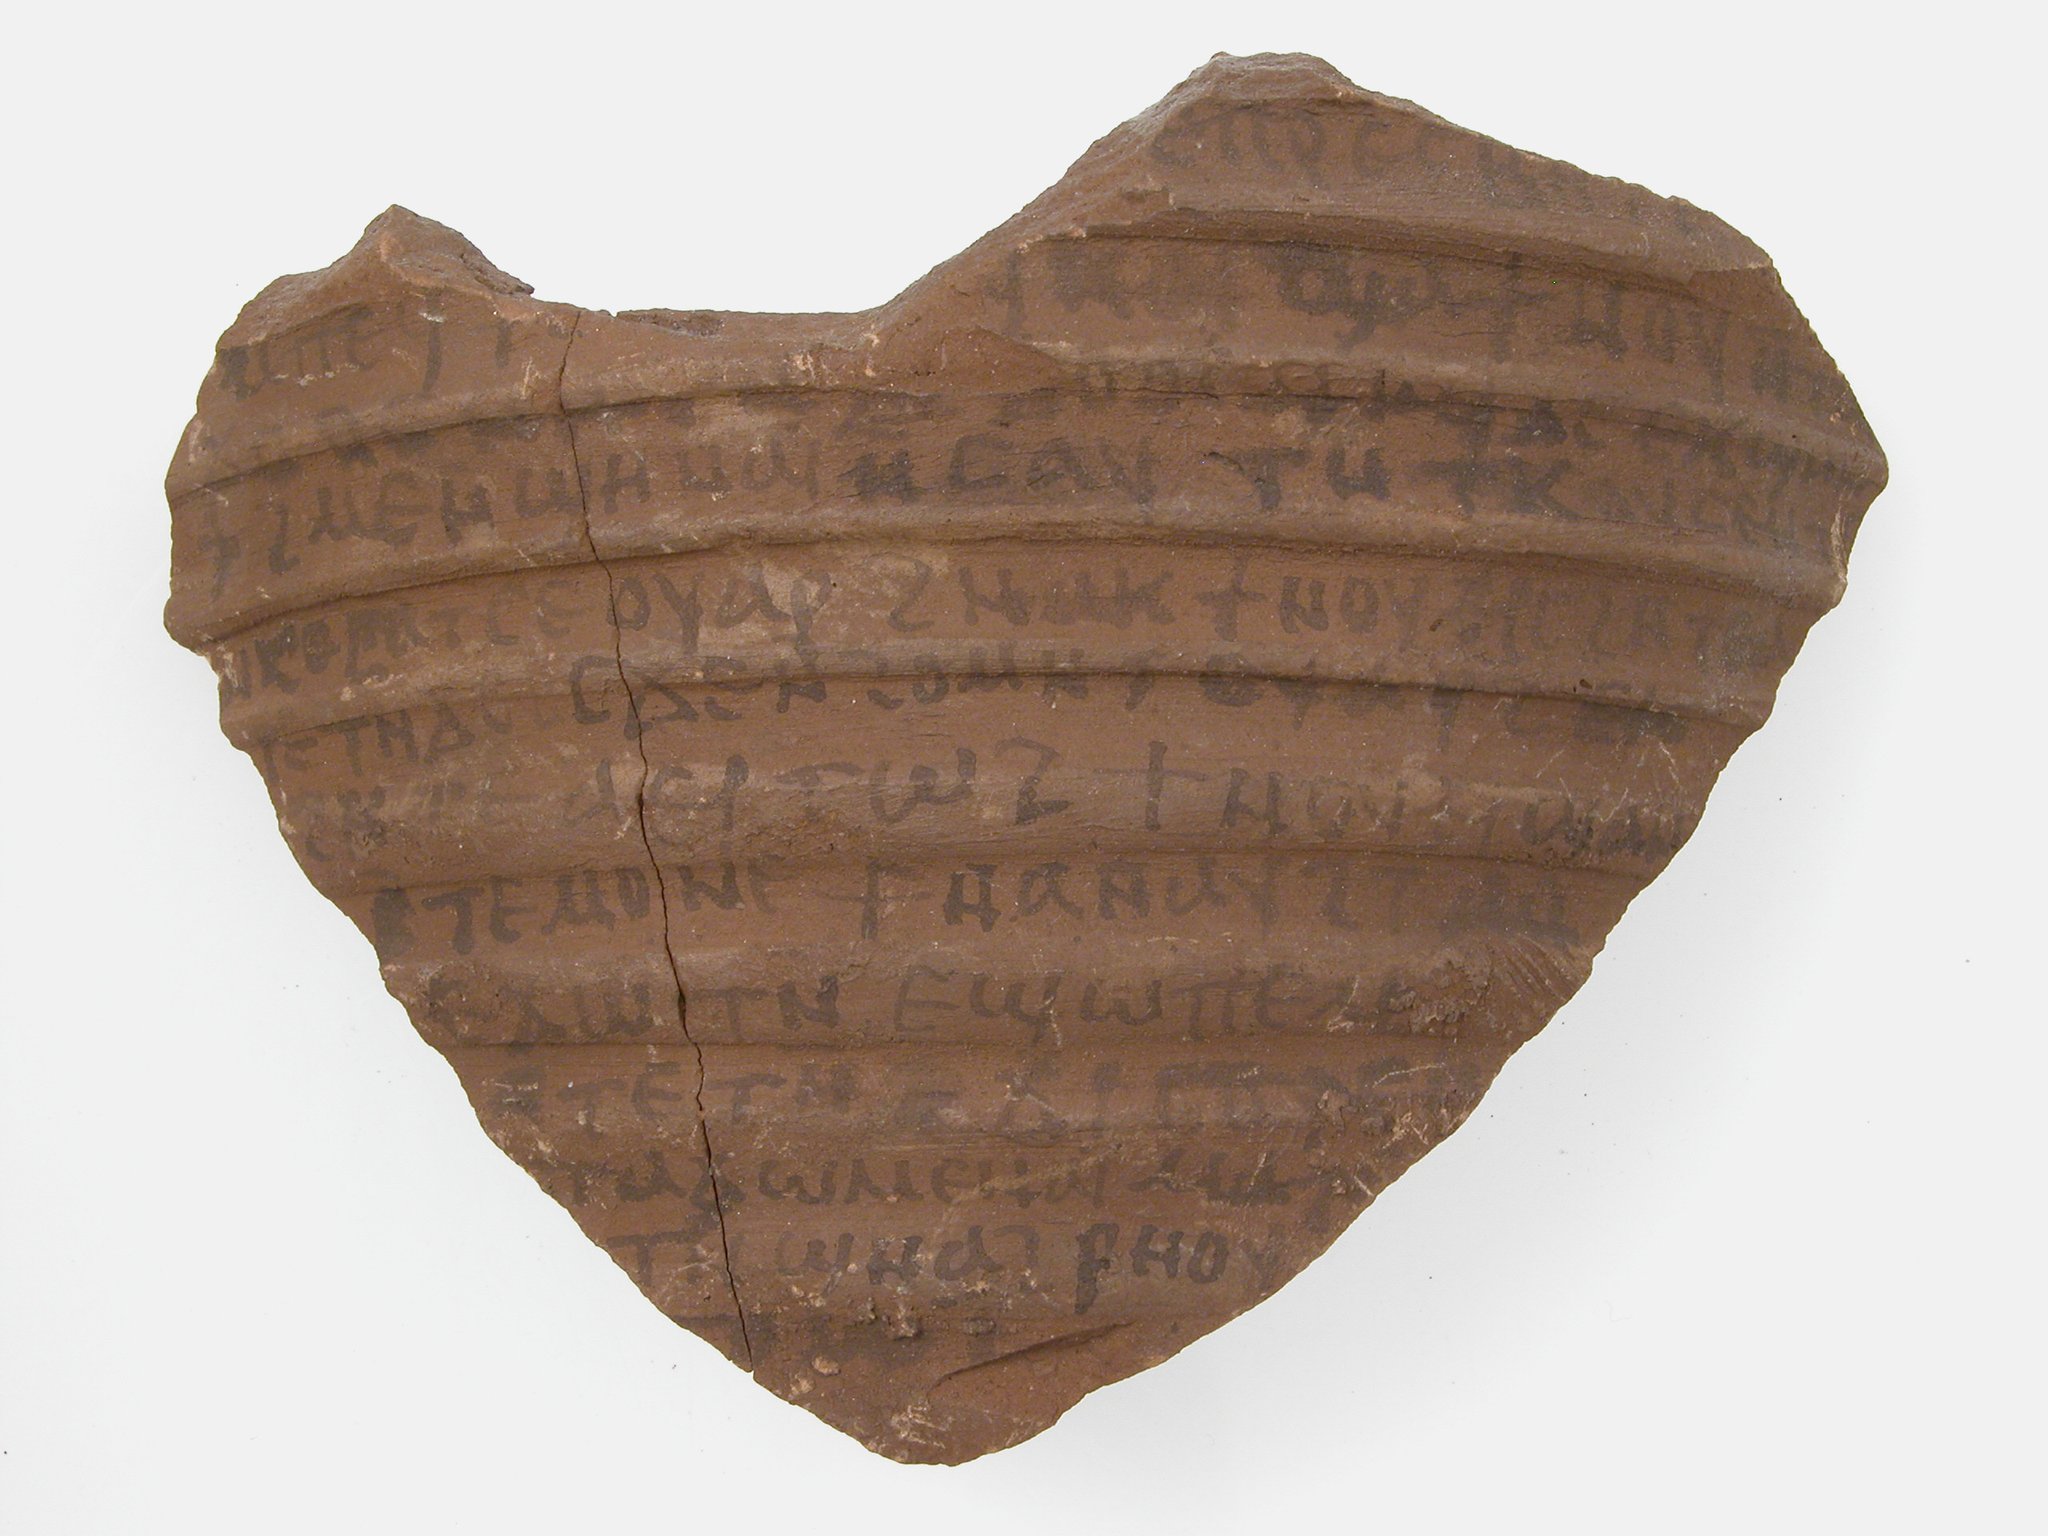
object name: ostrakon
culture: coptic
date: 601-700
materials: ink, pottery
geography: egypt